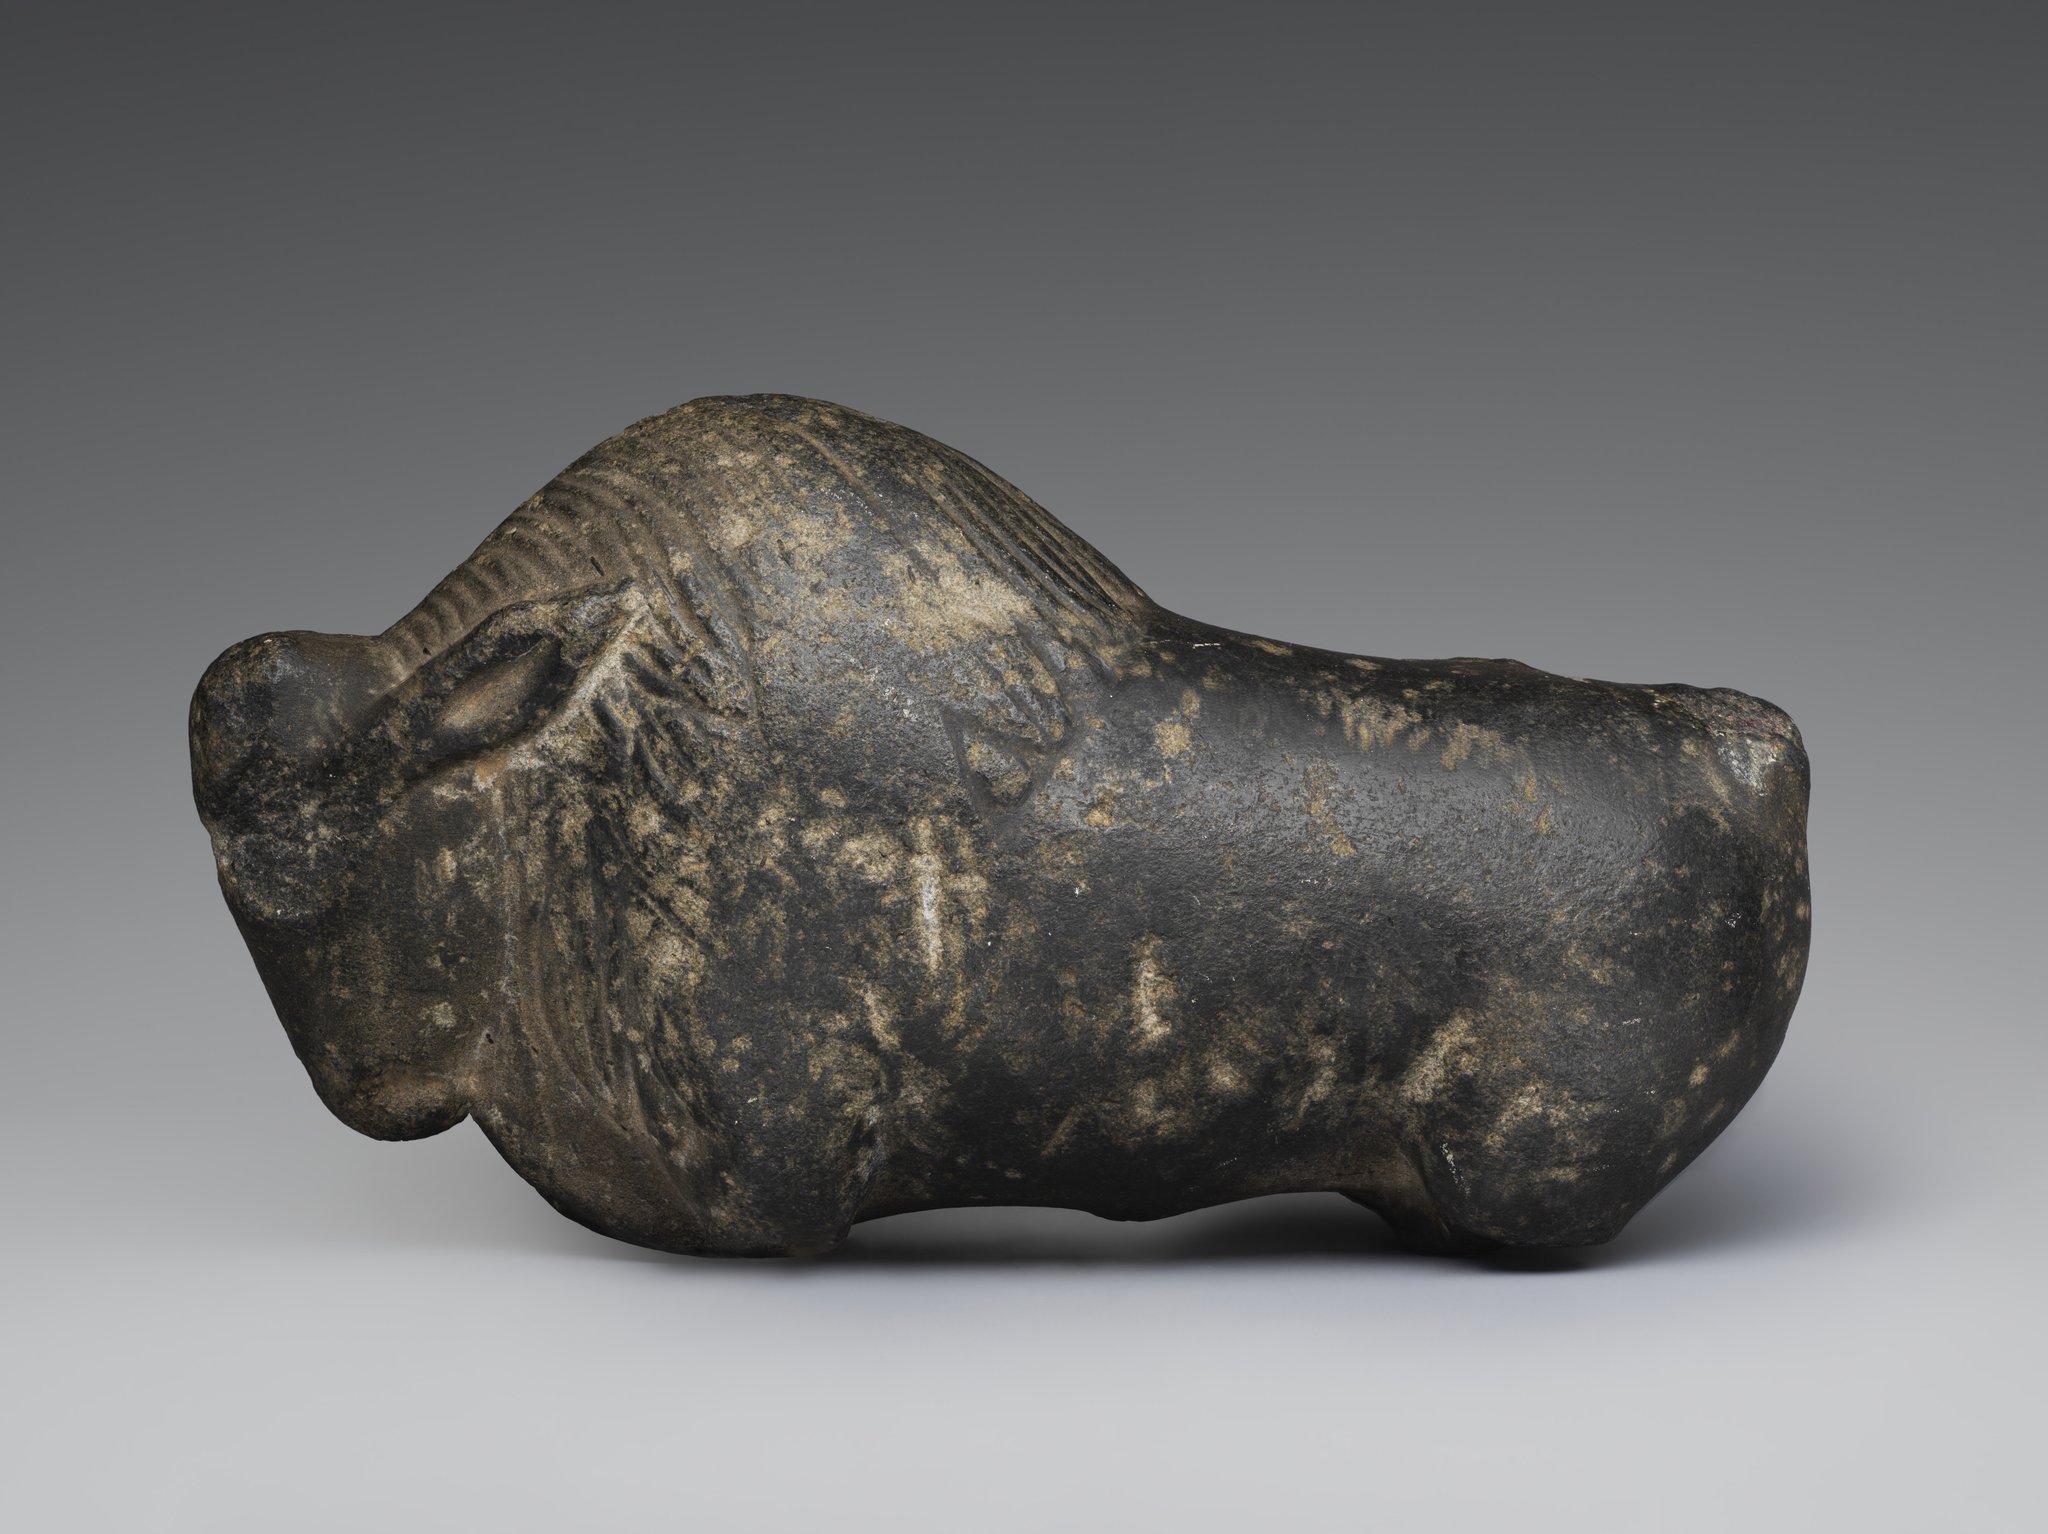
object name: sculpture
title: Bison figure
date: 3000-2001 BCE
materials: marble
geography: mesopotamia or syria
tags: animals